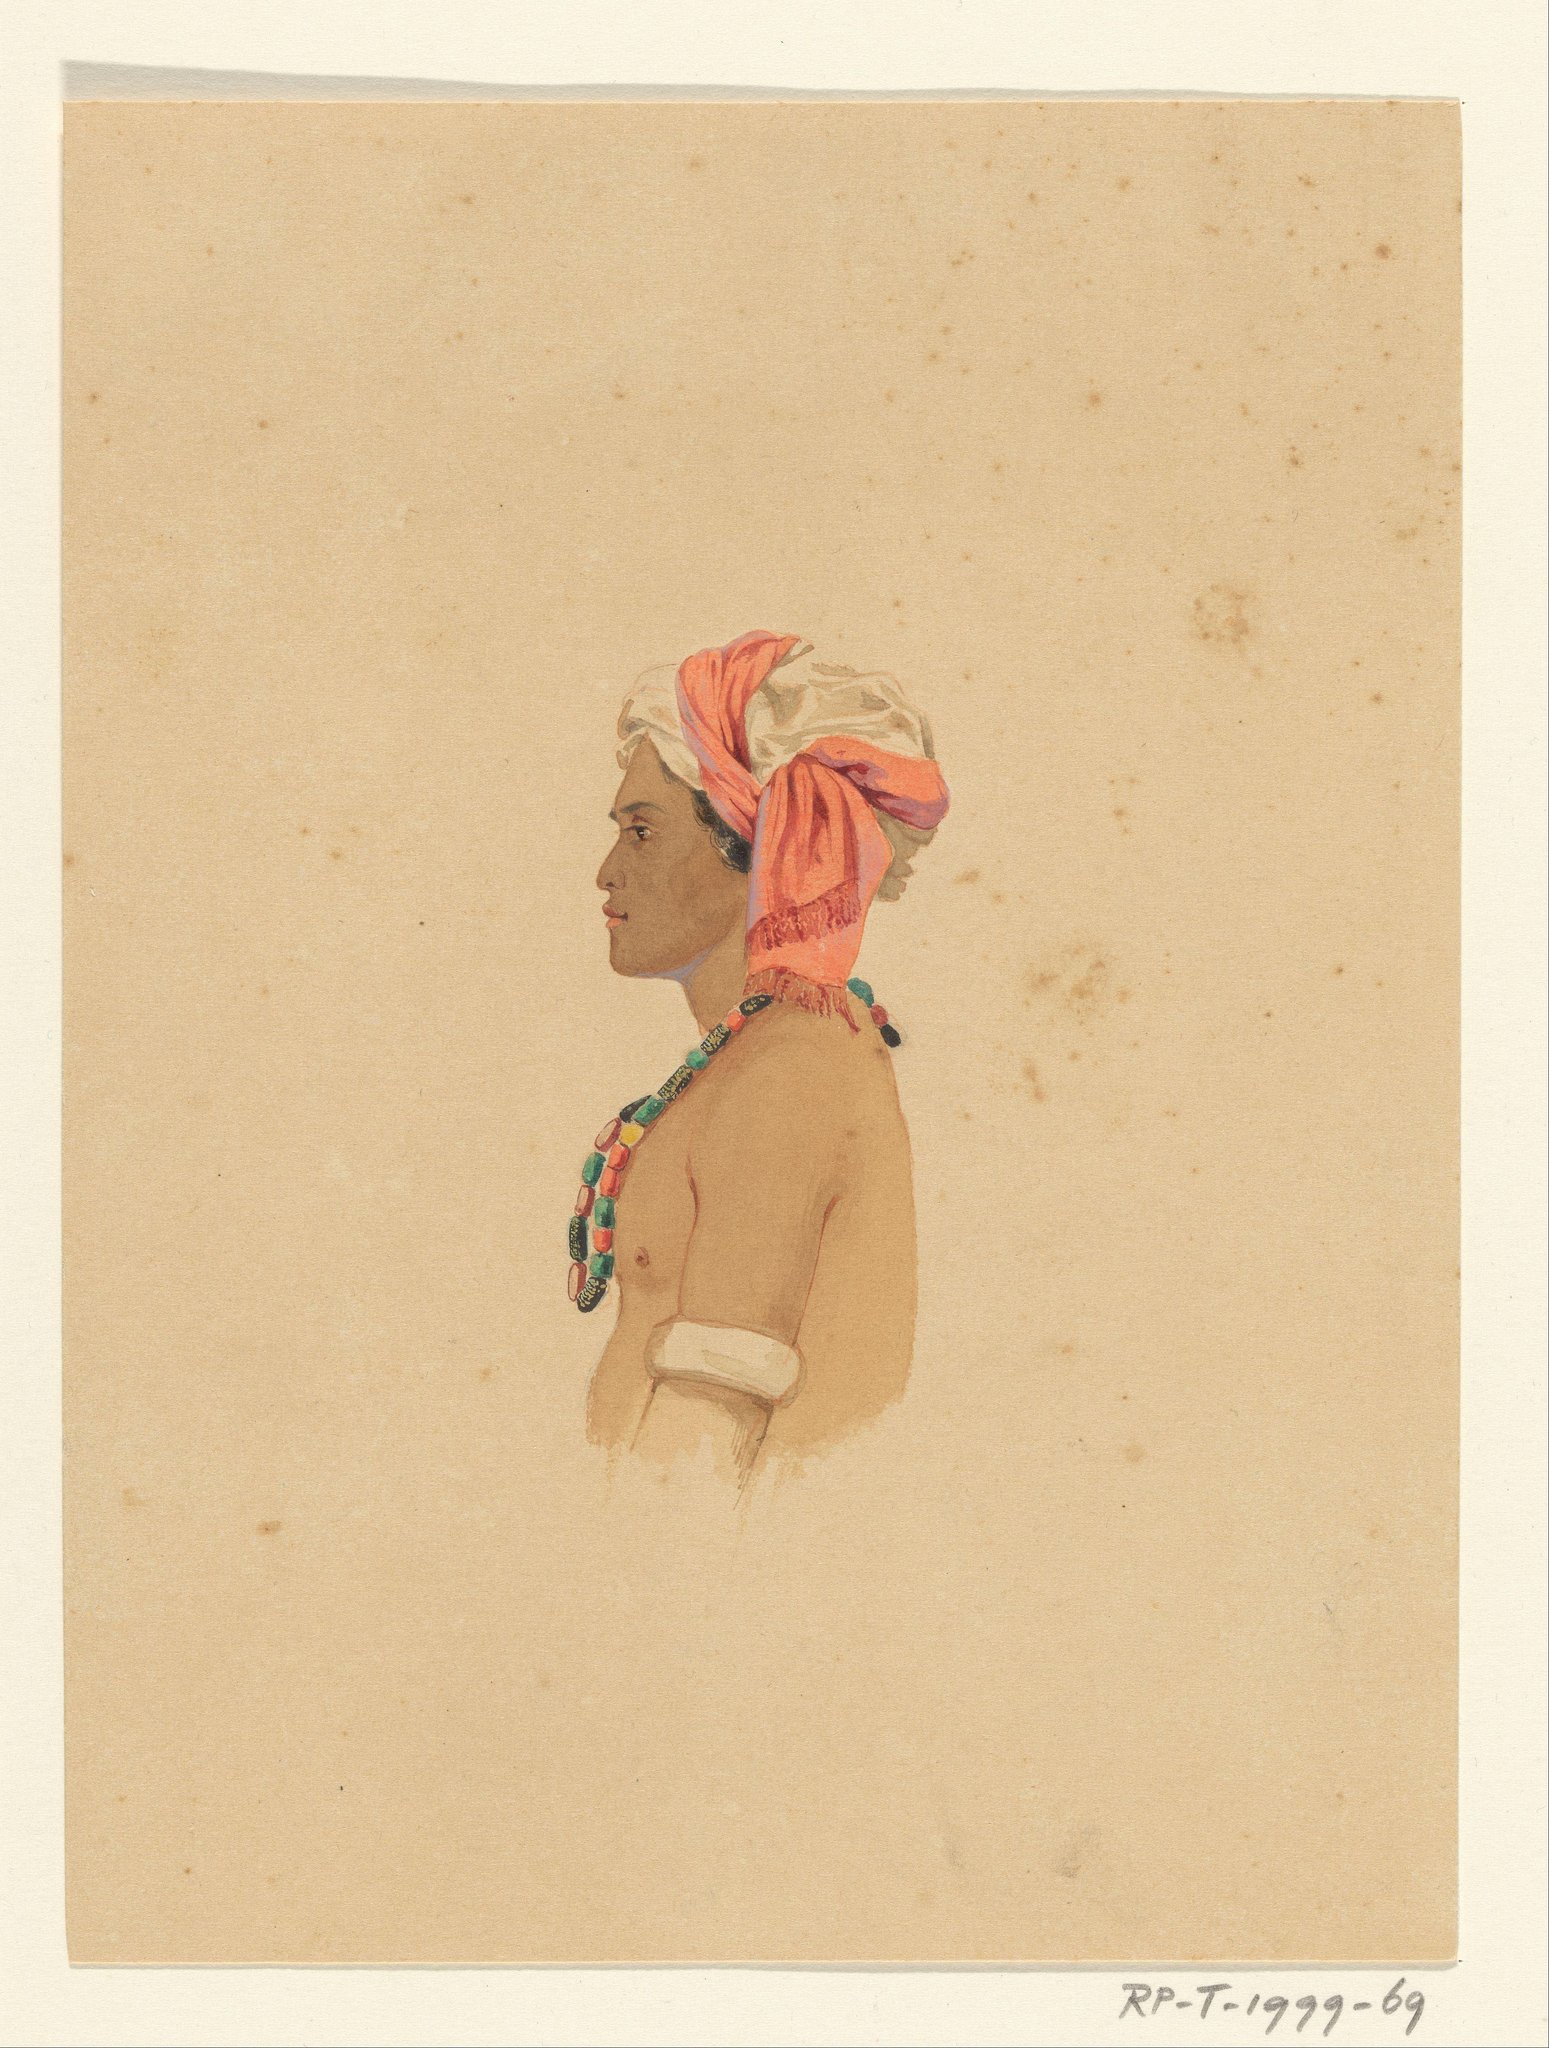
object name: watercolor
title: Portret van een man van de Aru eilanden, in profiel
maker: ernest alfred hardouin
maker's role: draughtsman, painter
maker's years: 1820-1853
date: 1837-1854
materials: paper, pencil, watercolor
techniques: brush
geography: aru-eilanden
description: naar een tekening van A.J. Bik (oorspronkelijke tekening niet in portefeuilles). A.J. Bik was beschermer van E.A. Hardouin; arikel over deze collectie in Bulletin van het Rijksmuseum 49 [2001], nr. 4, pp. 342 e.v.